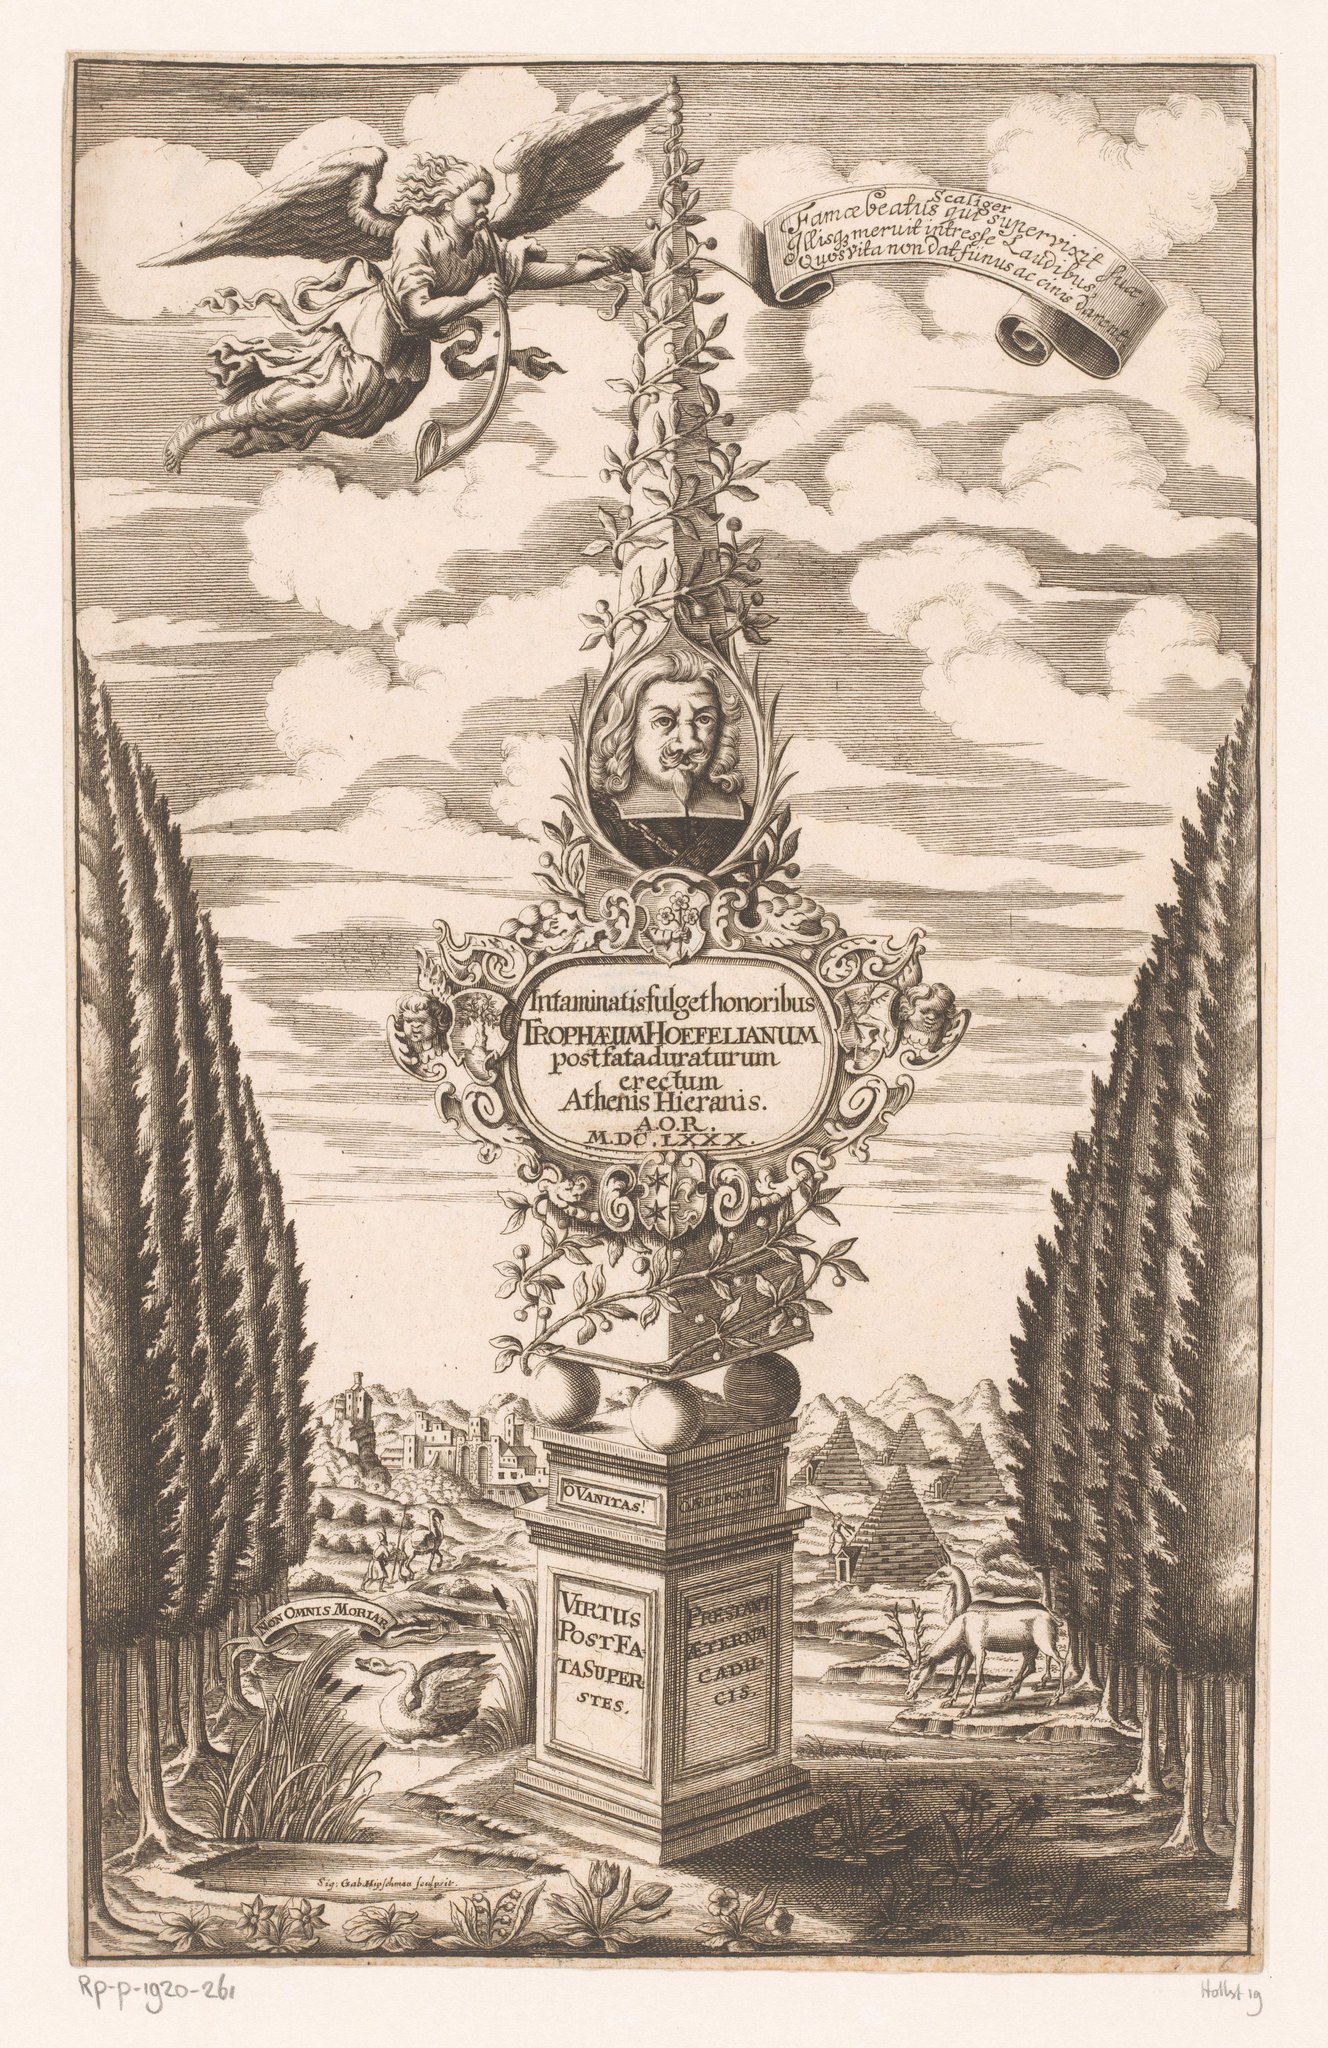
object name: print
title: Grafmonument voor de heer Hoeffel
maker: sigmund gabriel hipschmann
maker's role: painter, print maker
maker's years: 1639-1683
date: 1680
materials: paper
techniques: engraving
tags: trees: laurel (branch, stick), horn, trumpet, cornet, trombone, tuba, trees: cypress, historical persons, pyramid (marking grave), needle, obelisk (marking grave), angels, flowers (+ plants used symbolically)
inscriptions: collector's mark: Lugt 2228